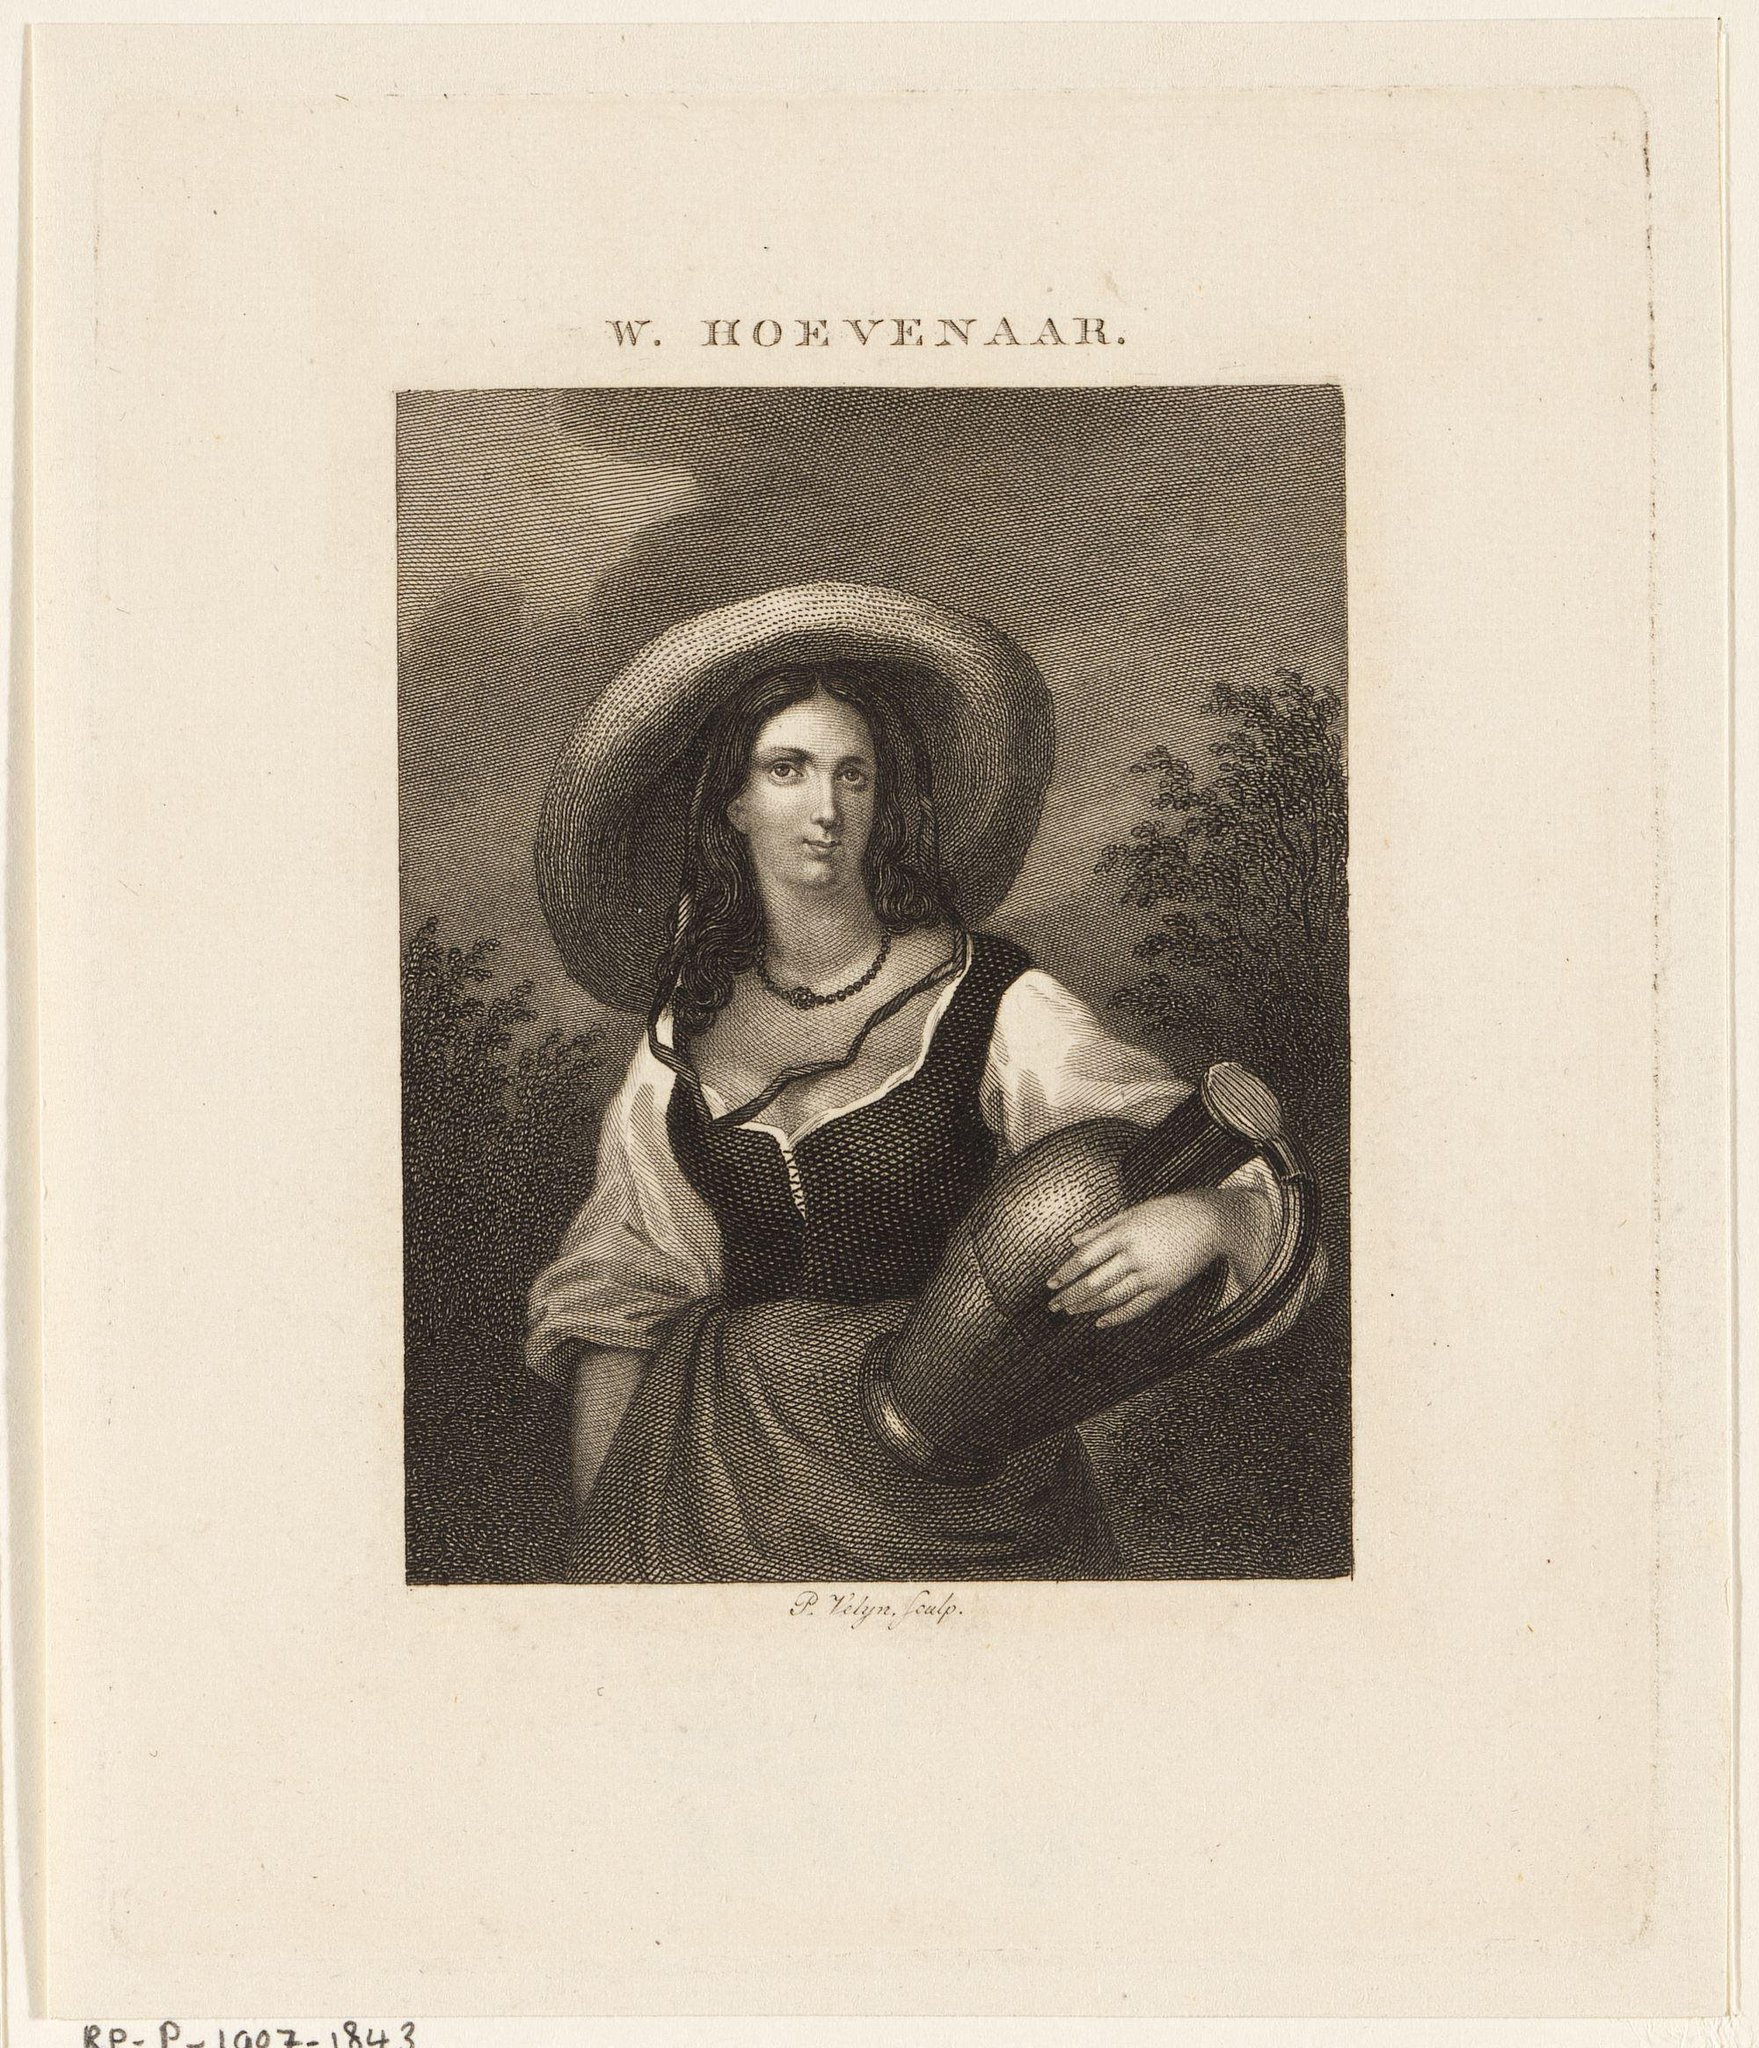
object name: print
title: Vrouw met kruik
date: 1797-1836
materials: paper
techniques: engraving, etching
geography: netherlands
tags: adolescent, young woman, maiden, container of ceramics: jar, jug, pot, vase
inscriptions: collector's mark: Lugt 2228